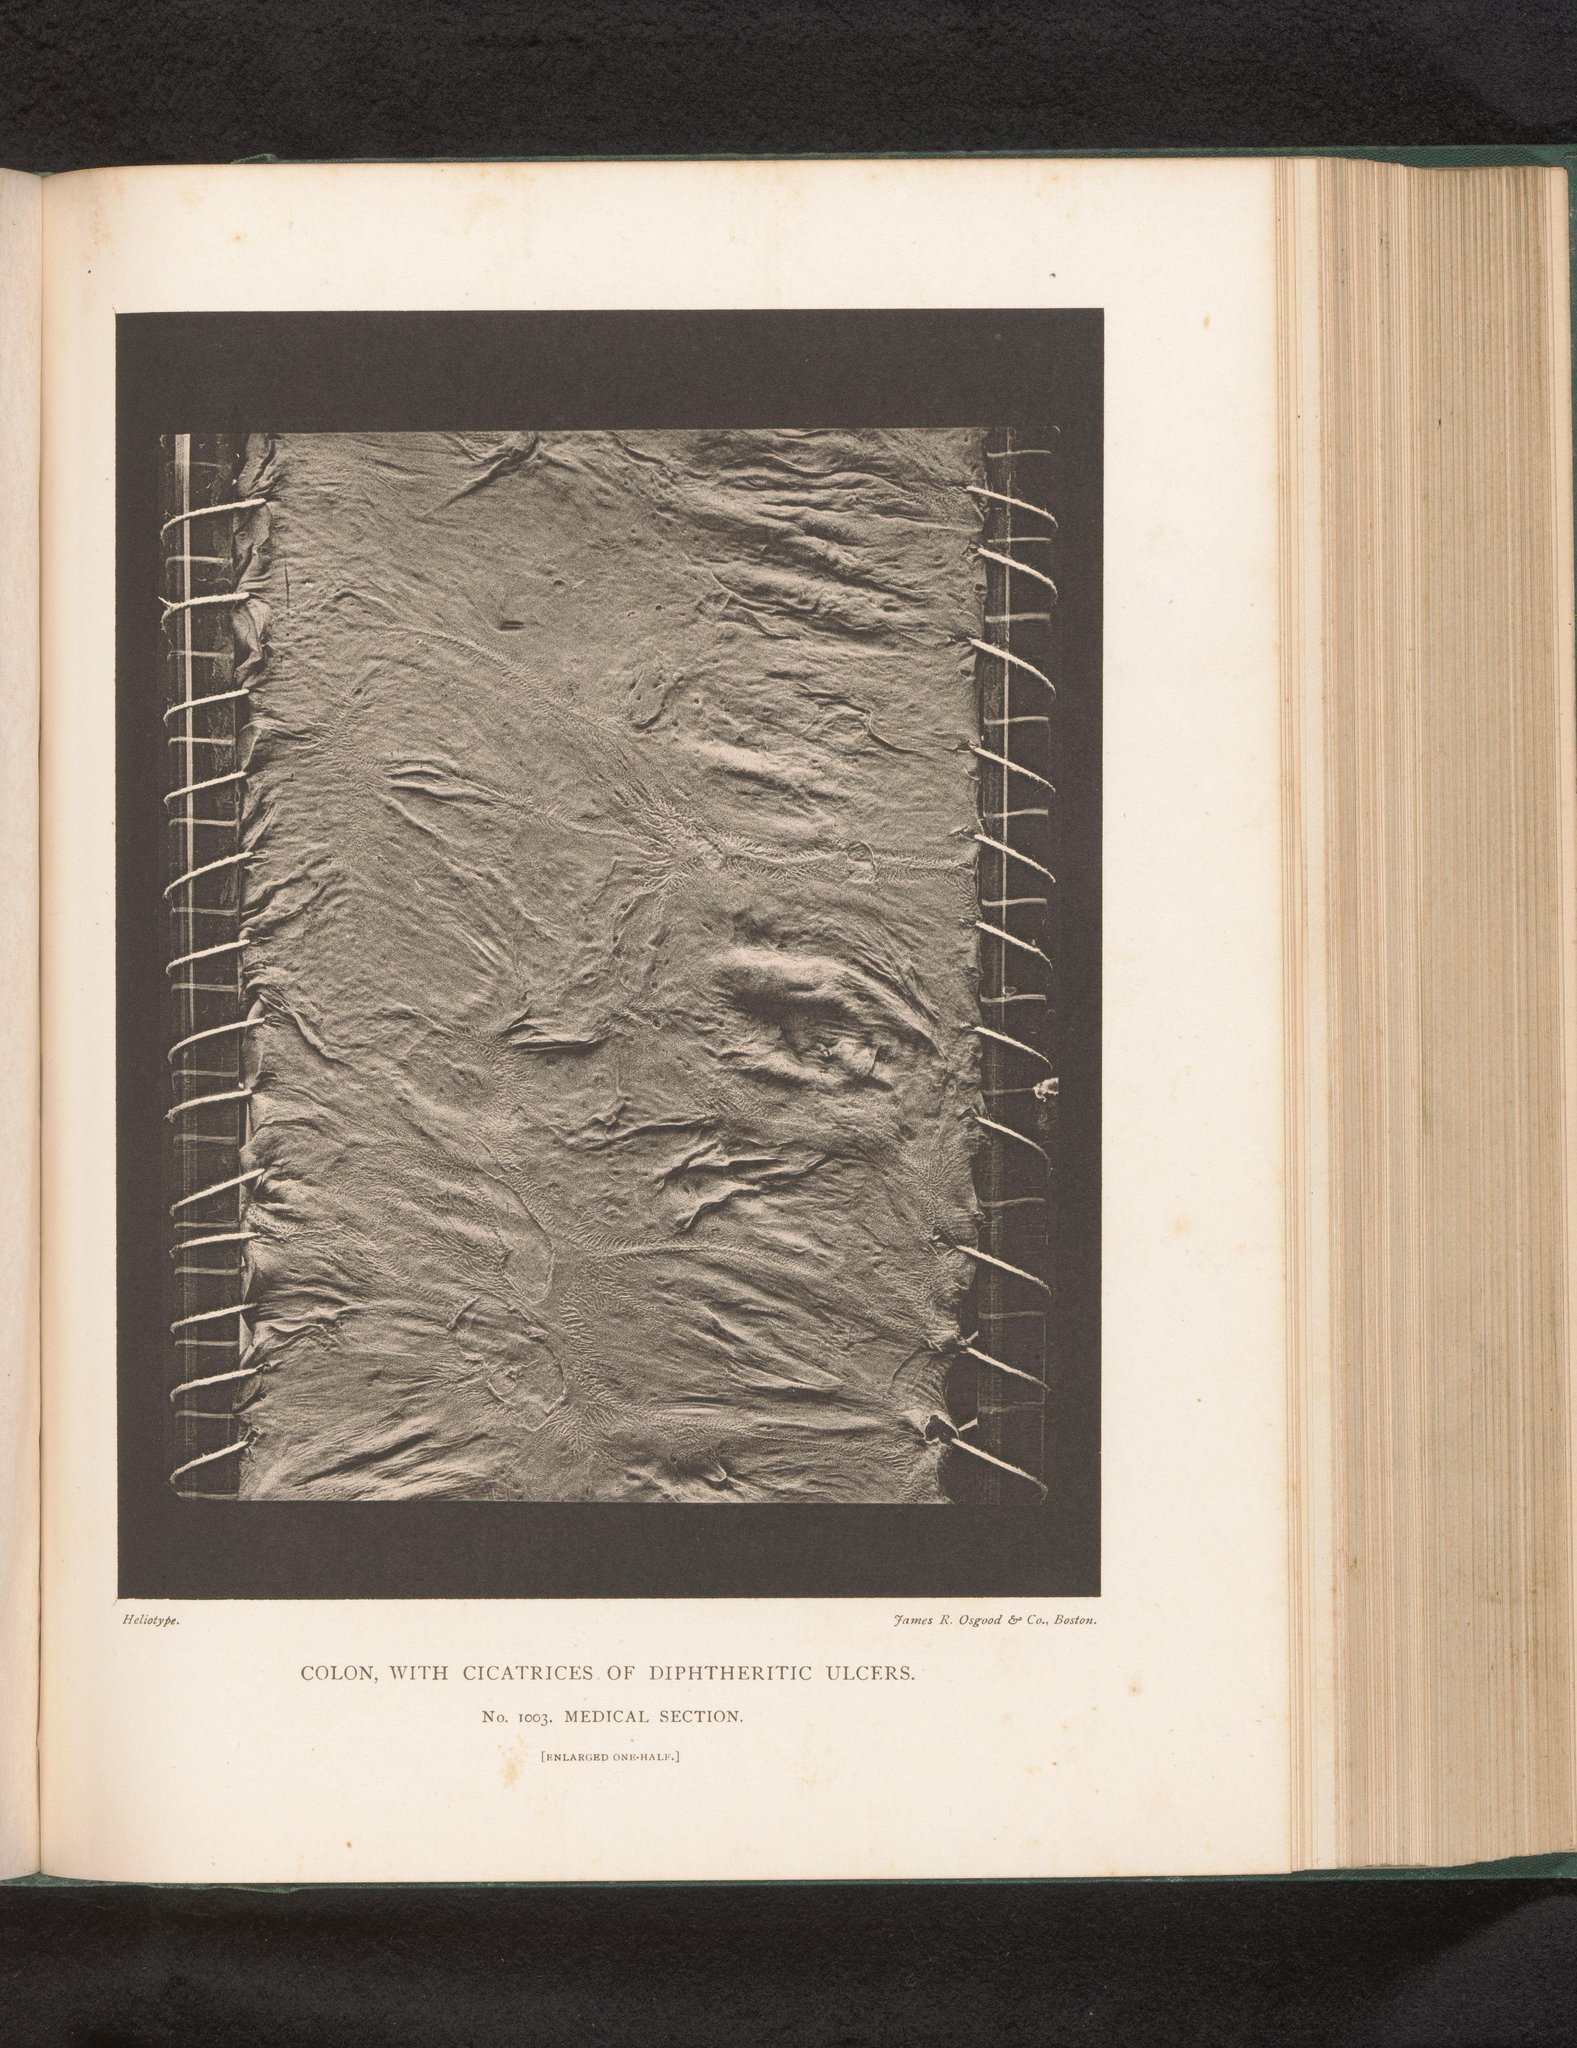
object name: page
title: Colon with Cicatrices of Diphtheritic Ulcers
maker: edward j. ward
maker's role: fotograaf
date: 1874-1879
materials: paper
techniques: photograph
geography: boston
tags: intestines, scar, cicatrix, ulcer, anatomical specimen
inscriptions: inscription: ‘[ENLARGED ONE-HALF.]’, number: ‘No. 1003. MEDICAL SECTION.’, inscription: ‘Heliotype’